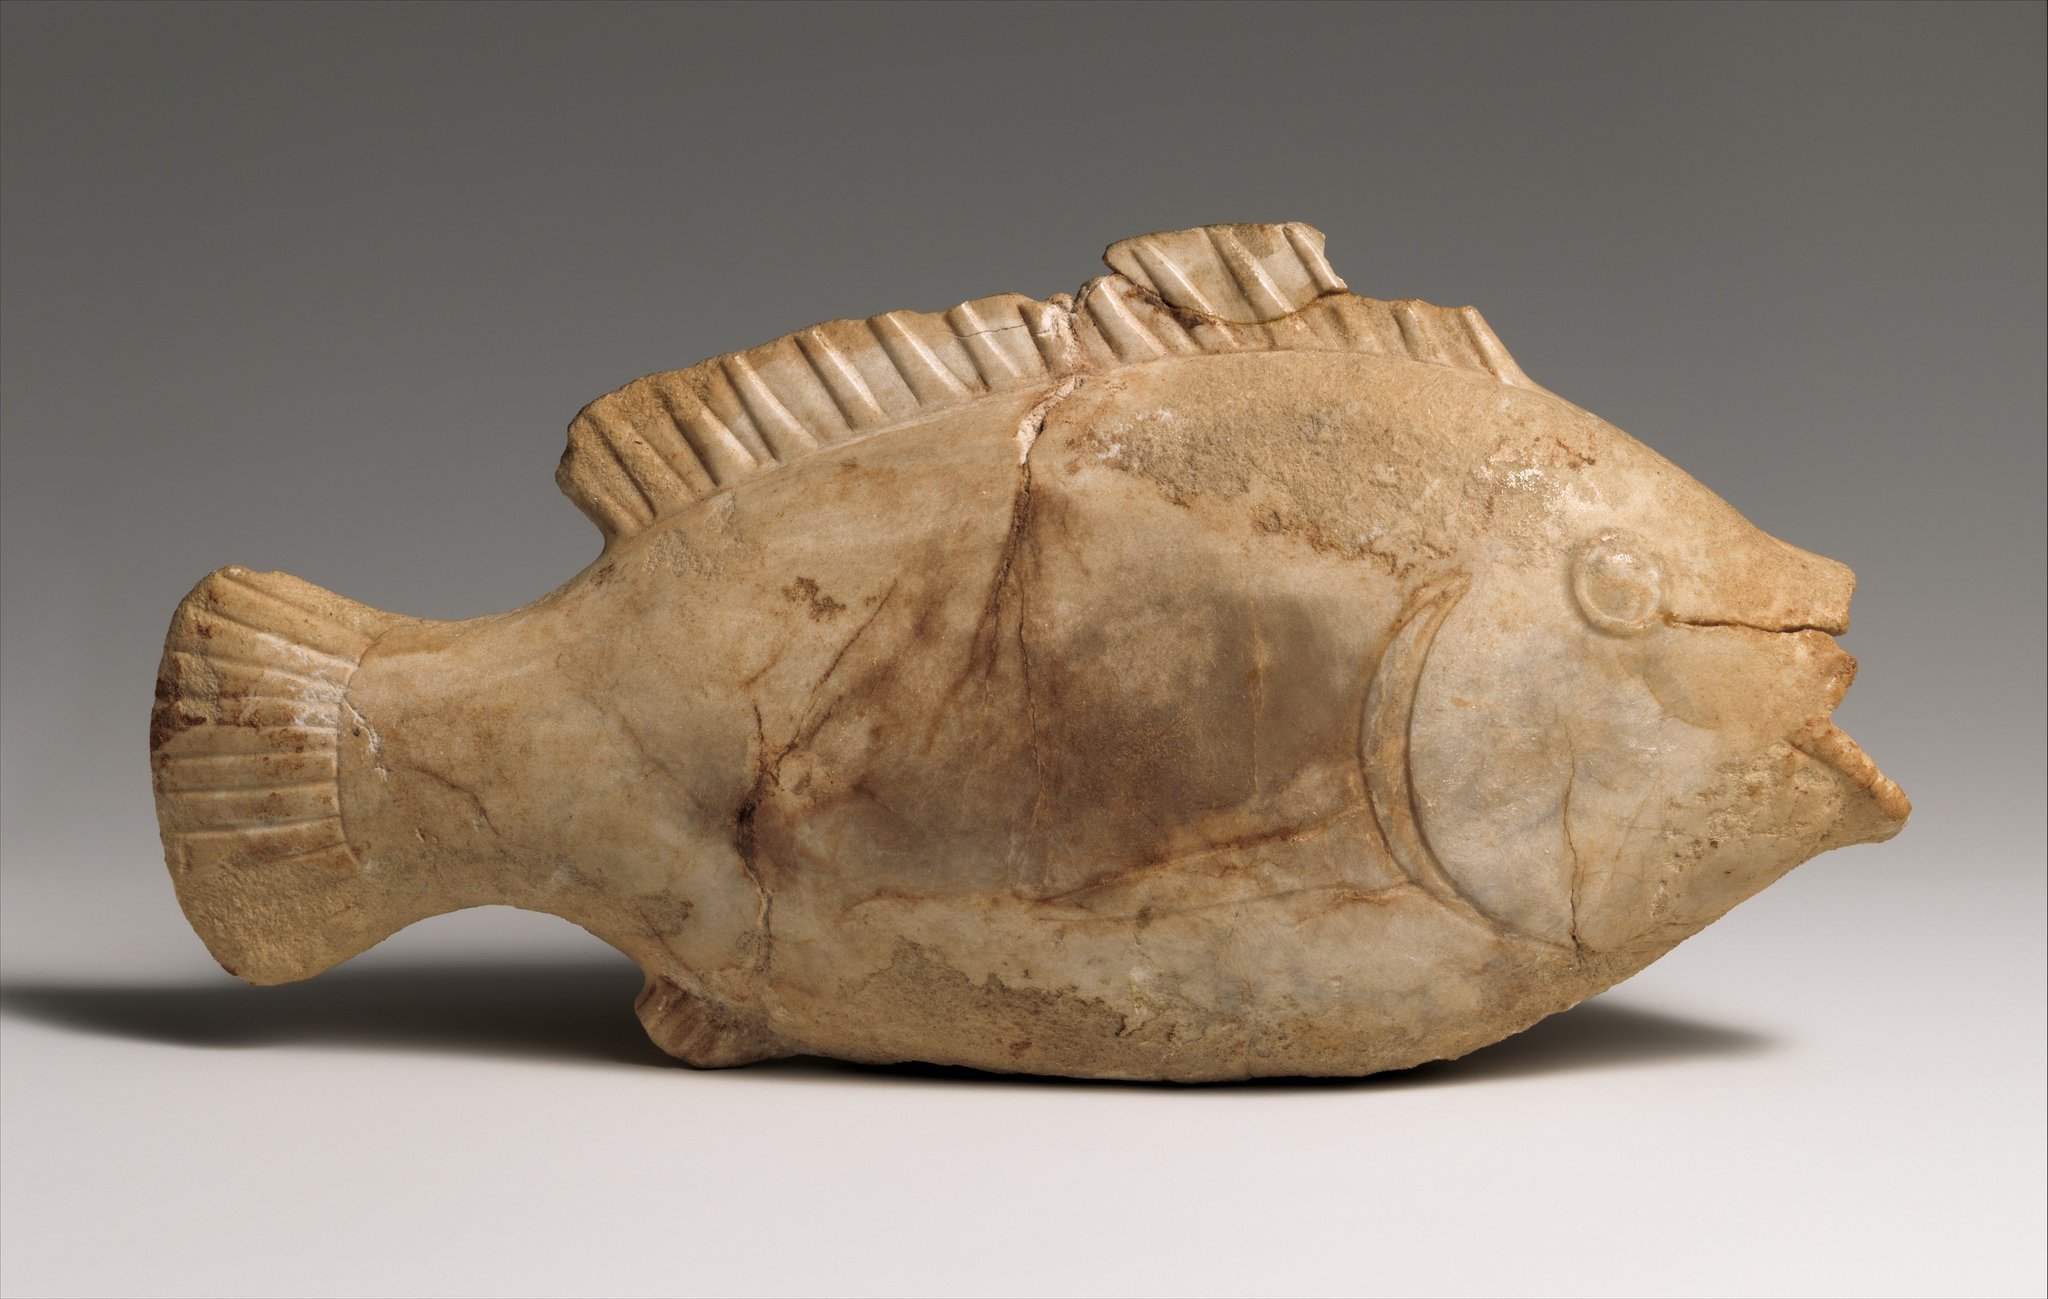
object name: ointment jar, bolti fish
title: Ointment vase in the shape of a bolti fish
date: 1800-1550 BCE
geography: northern upper egypt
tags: fish